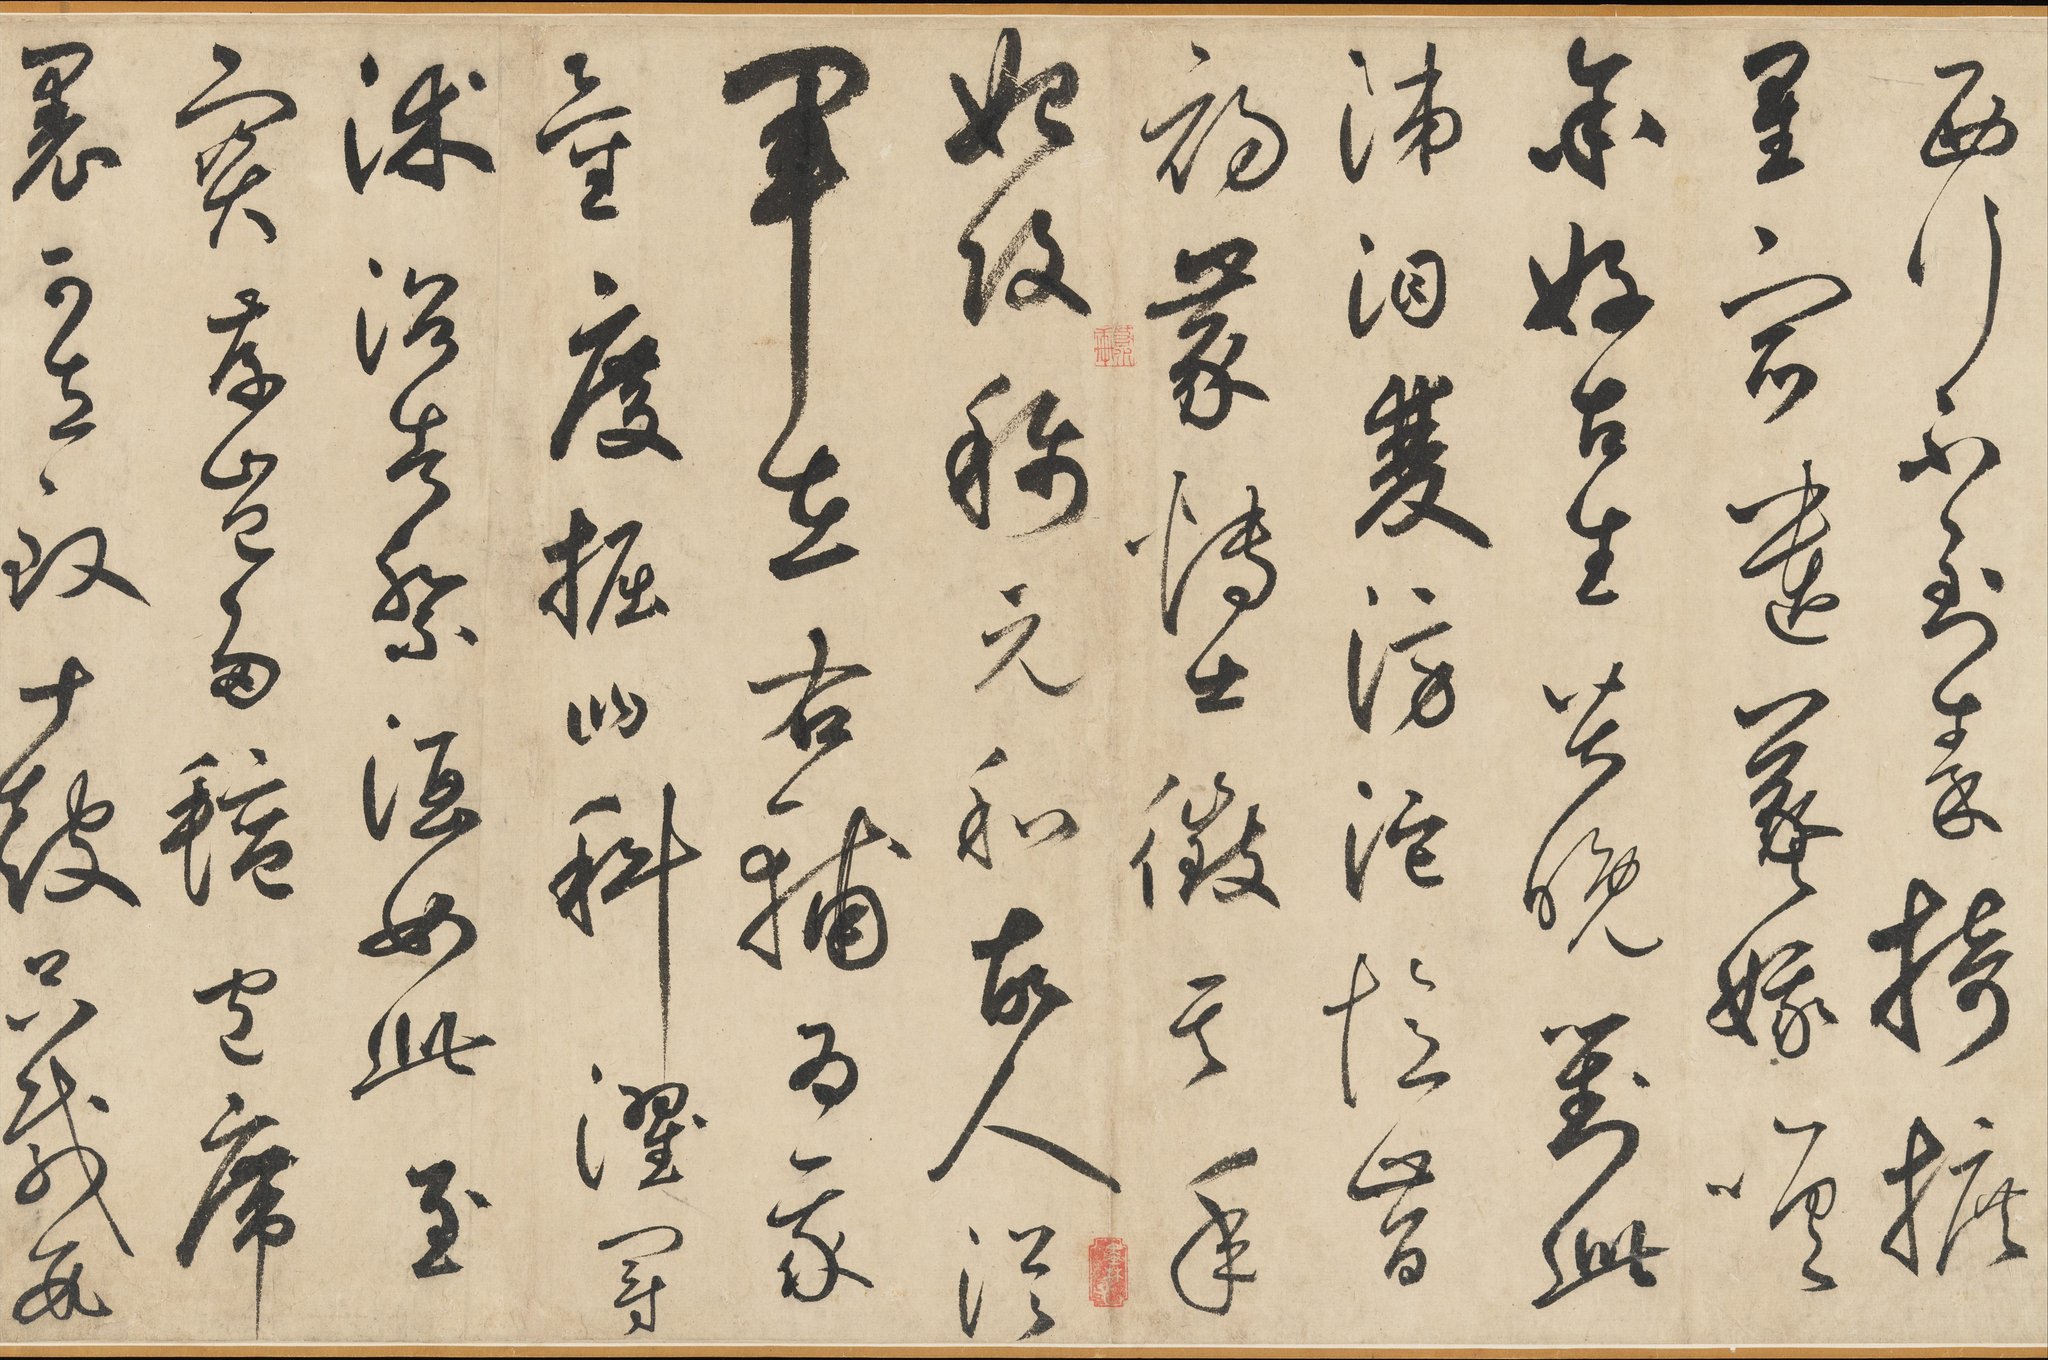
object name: handscroll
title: Song of the Stone Drums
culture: chinese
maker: xianyu shu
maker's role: artist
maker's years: 1246-1302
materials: ink, paper